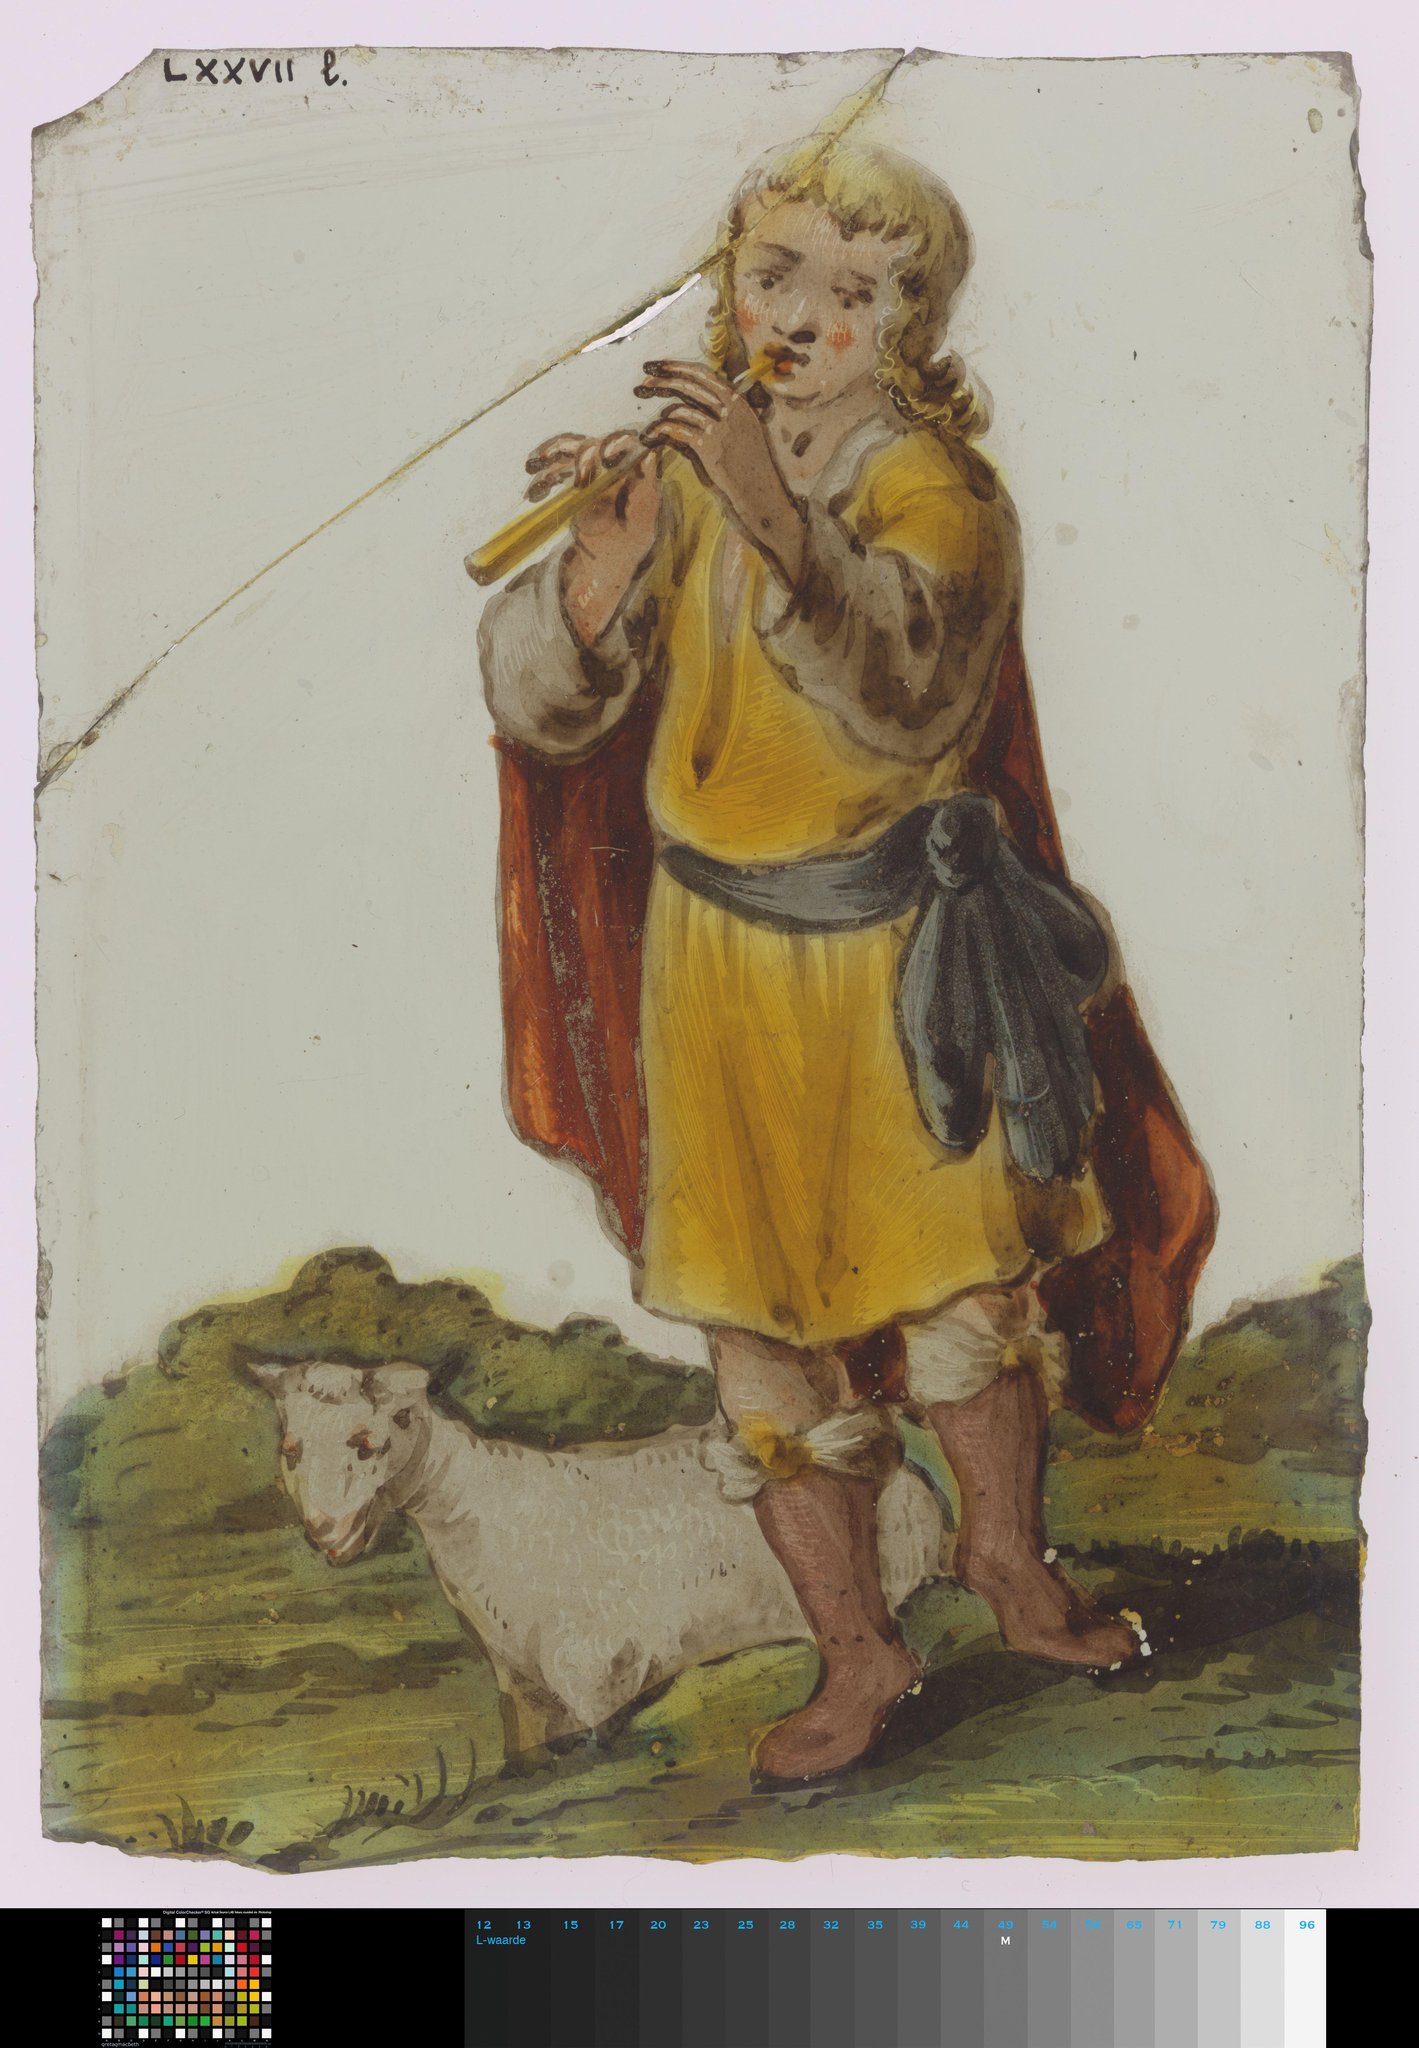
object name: light window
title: Ruit met fluitspelende herder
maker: Anonymous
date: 1650-1675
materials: glass, lead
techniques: enamel painting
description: Een ruit met emailschildering van een jonge herder met en fluit, naast hem een schaap